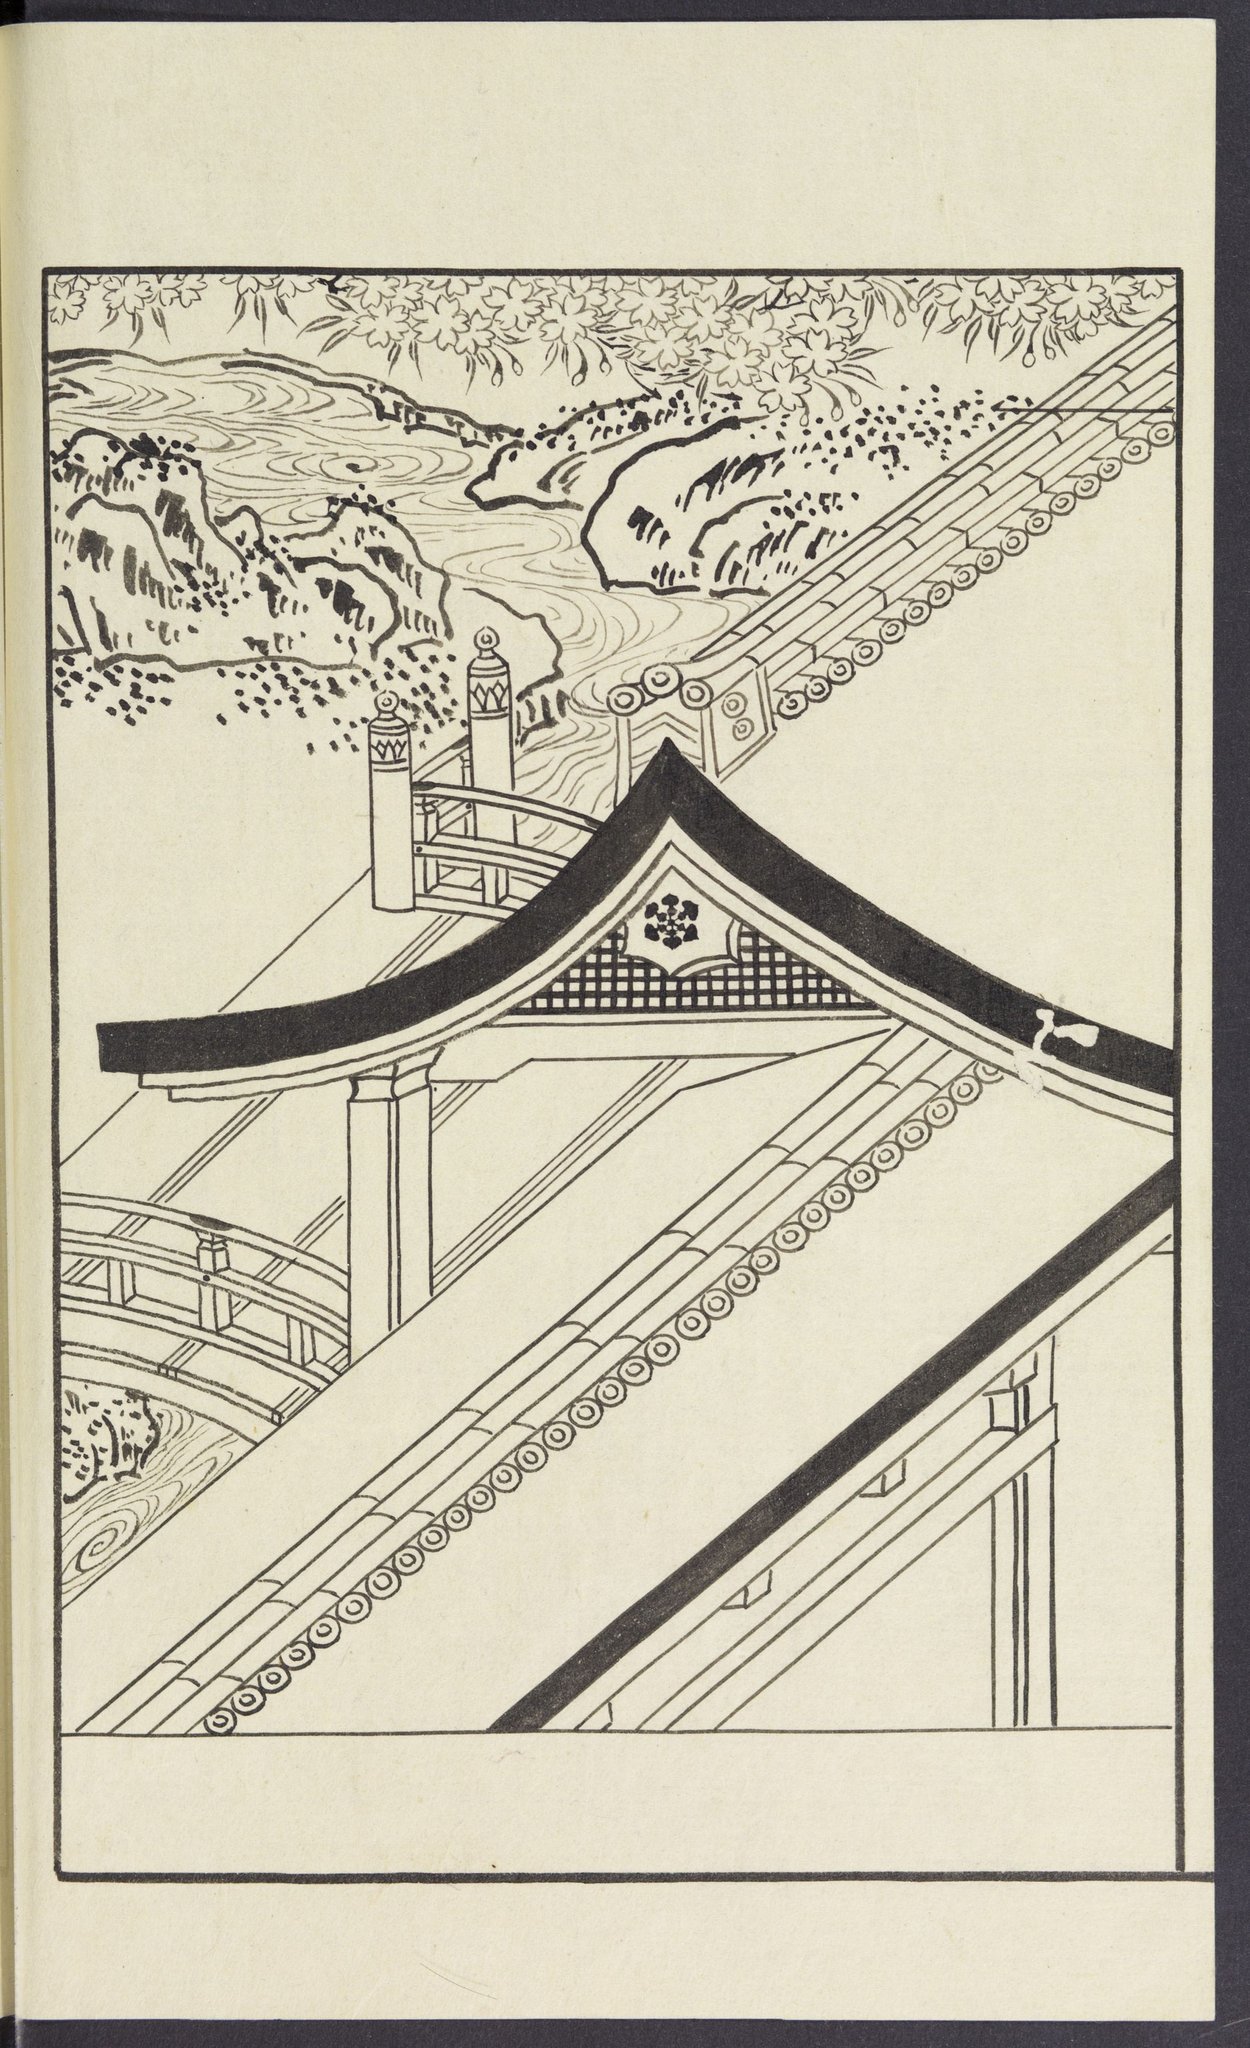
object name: illustrated book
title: Story of Michizane Sugawara, known as Tenjin (Tenjin engi) 天神縁起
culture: japanese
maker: reizen saburo tametaka 冷泉(岡田)為恭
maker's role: artist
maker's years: 1864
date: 1801-1900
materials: ink, paper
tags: buildings,men,women